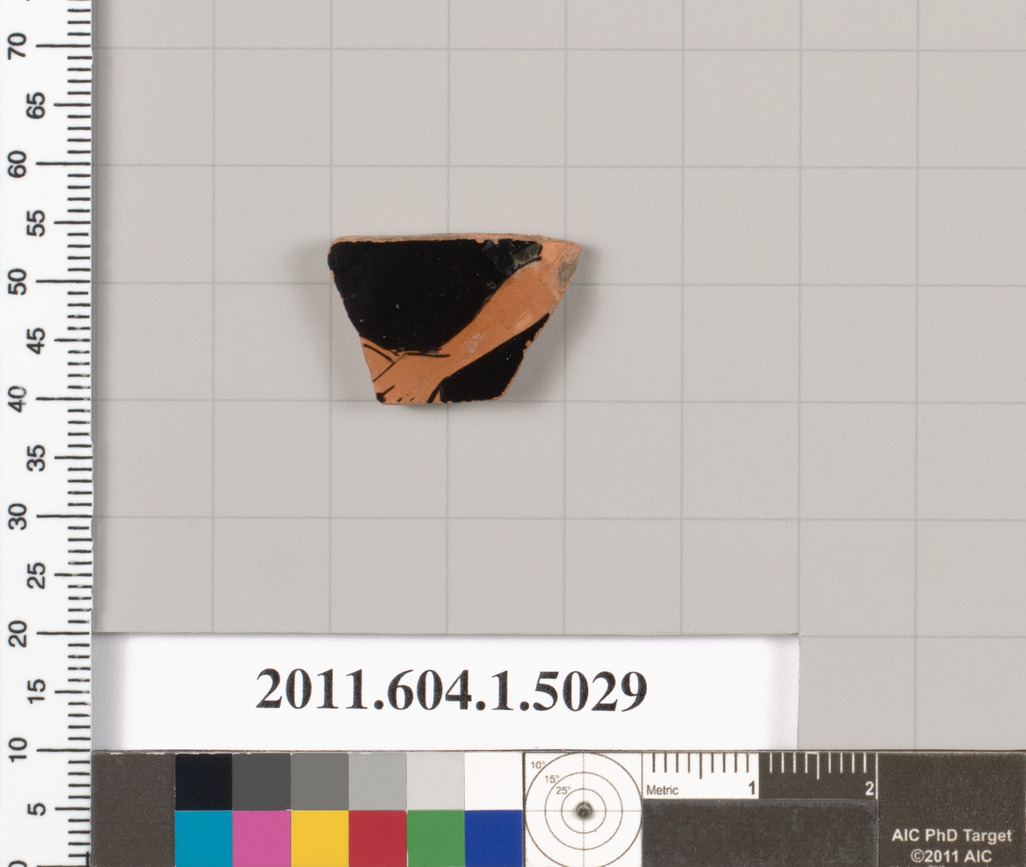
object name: kylix fragment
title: Terracotta fragment of a kylix (drinking cup)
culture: greek, attic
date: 500-480 BCE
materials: terracotta